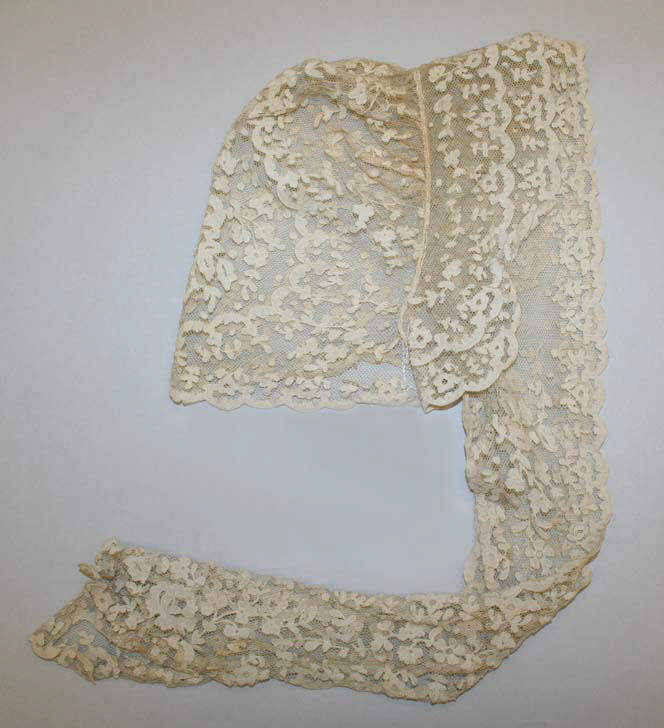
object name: cap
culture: american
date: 1834-1866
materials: cotton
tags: flowers